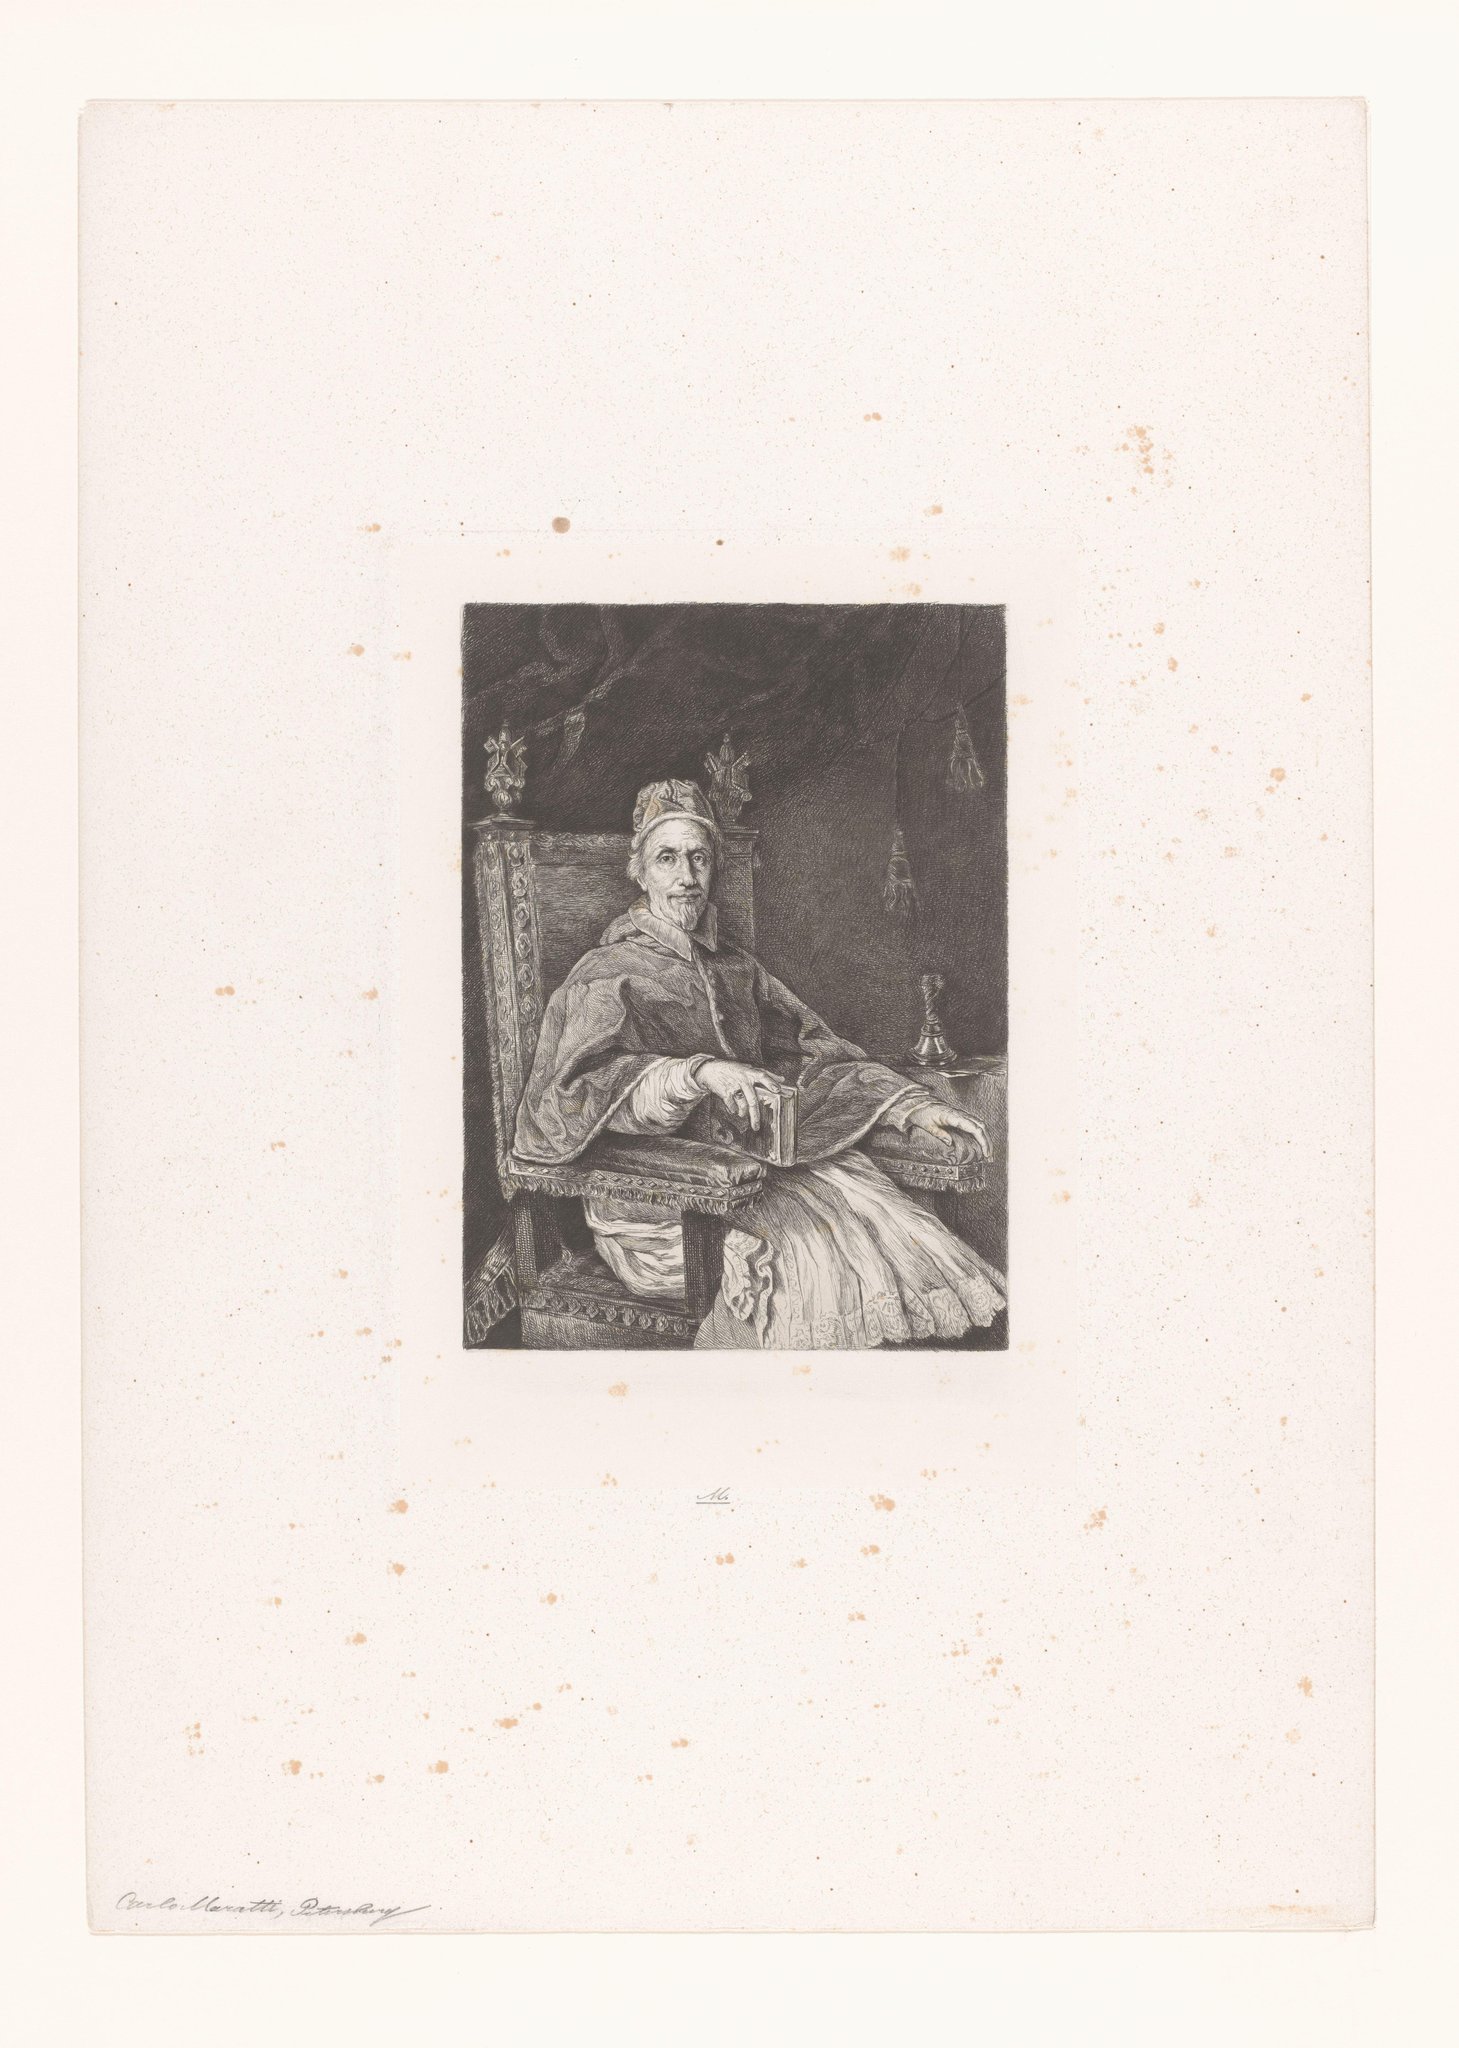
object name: print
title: Portret van paus Clemens IX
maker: nikolay semyonovich mosolov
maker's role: print maker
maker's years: 1847-1914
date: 1857-1914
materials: paper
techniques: drypoint, etching, intaglio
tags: clemens ix, pope